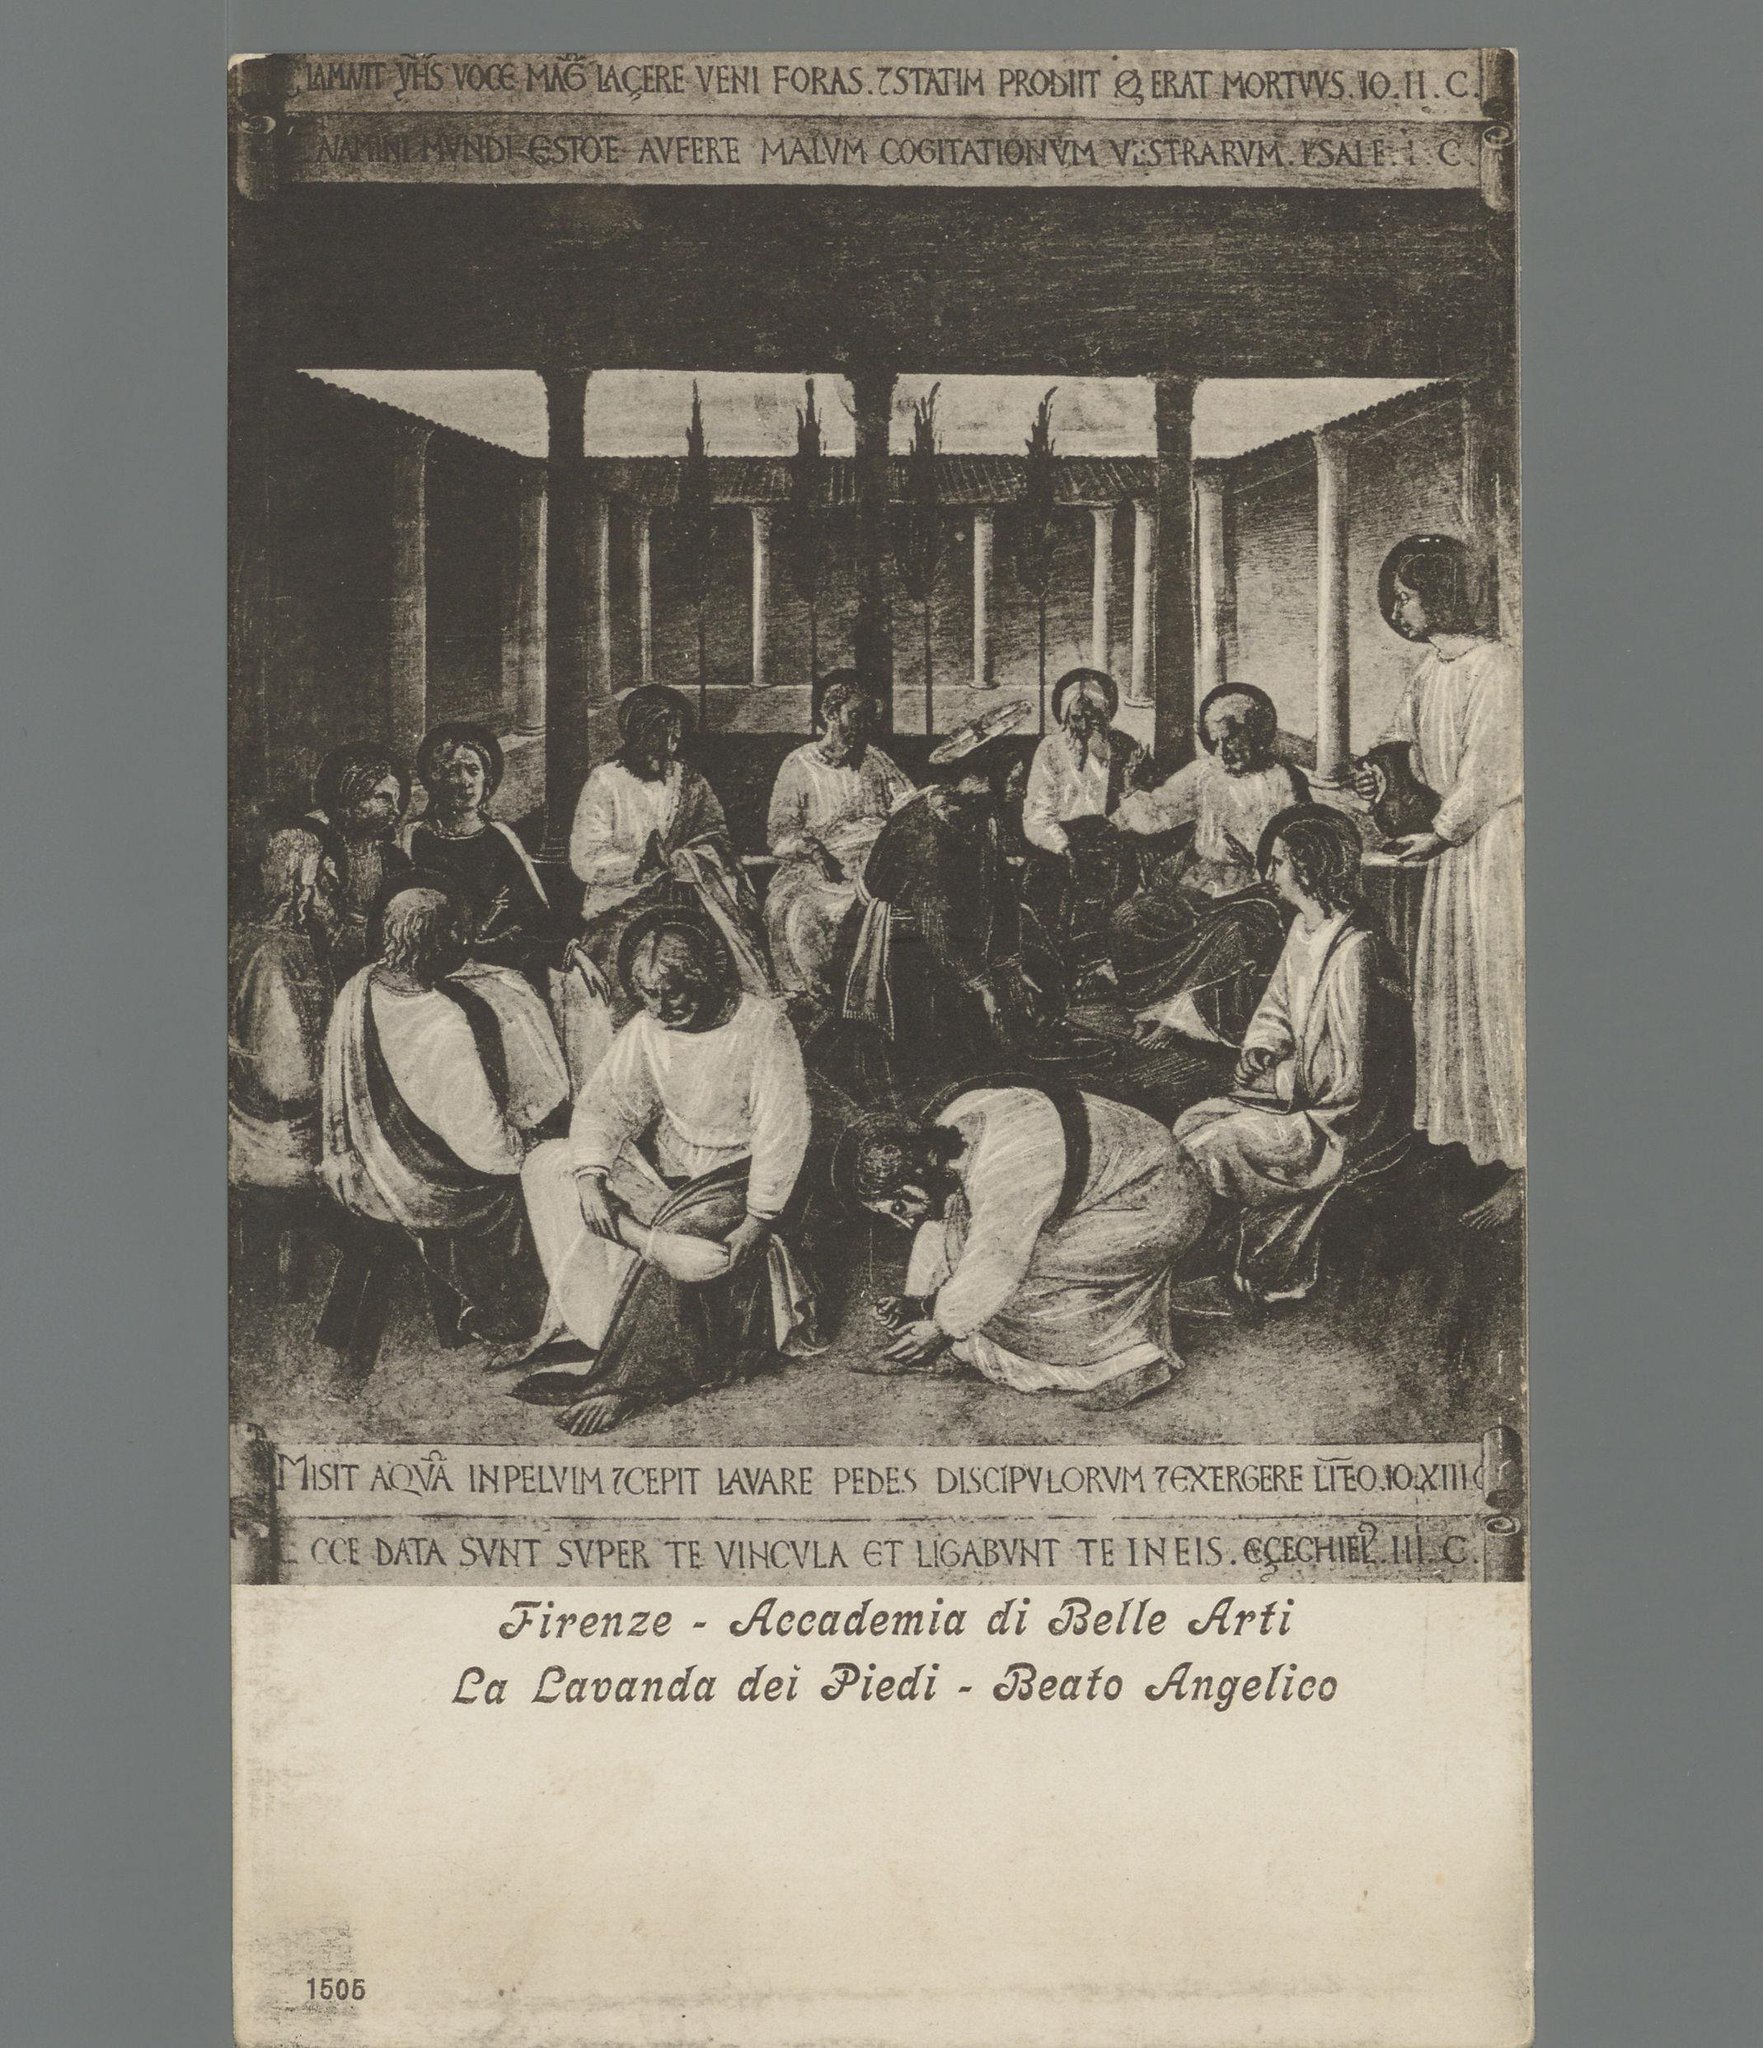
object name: ansichtkaart, prentbriefkaart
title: Firenze - Accademia di Belle Arti. La Lavanda dei Piedi - Beato Angelico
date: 1906-1930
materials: cardboard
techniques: photograph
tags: permanent exhibition, museum, picture, painting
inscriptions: collector's mark: ‘AFE v S’, monogram